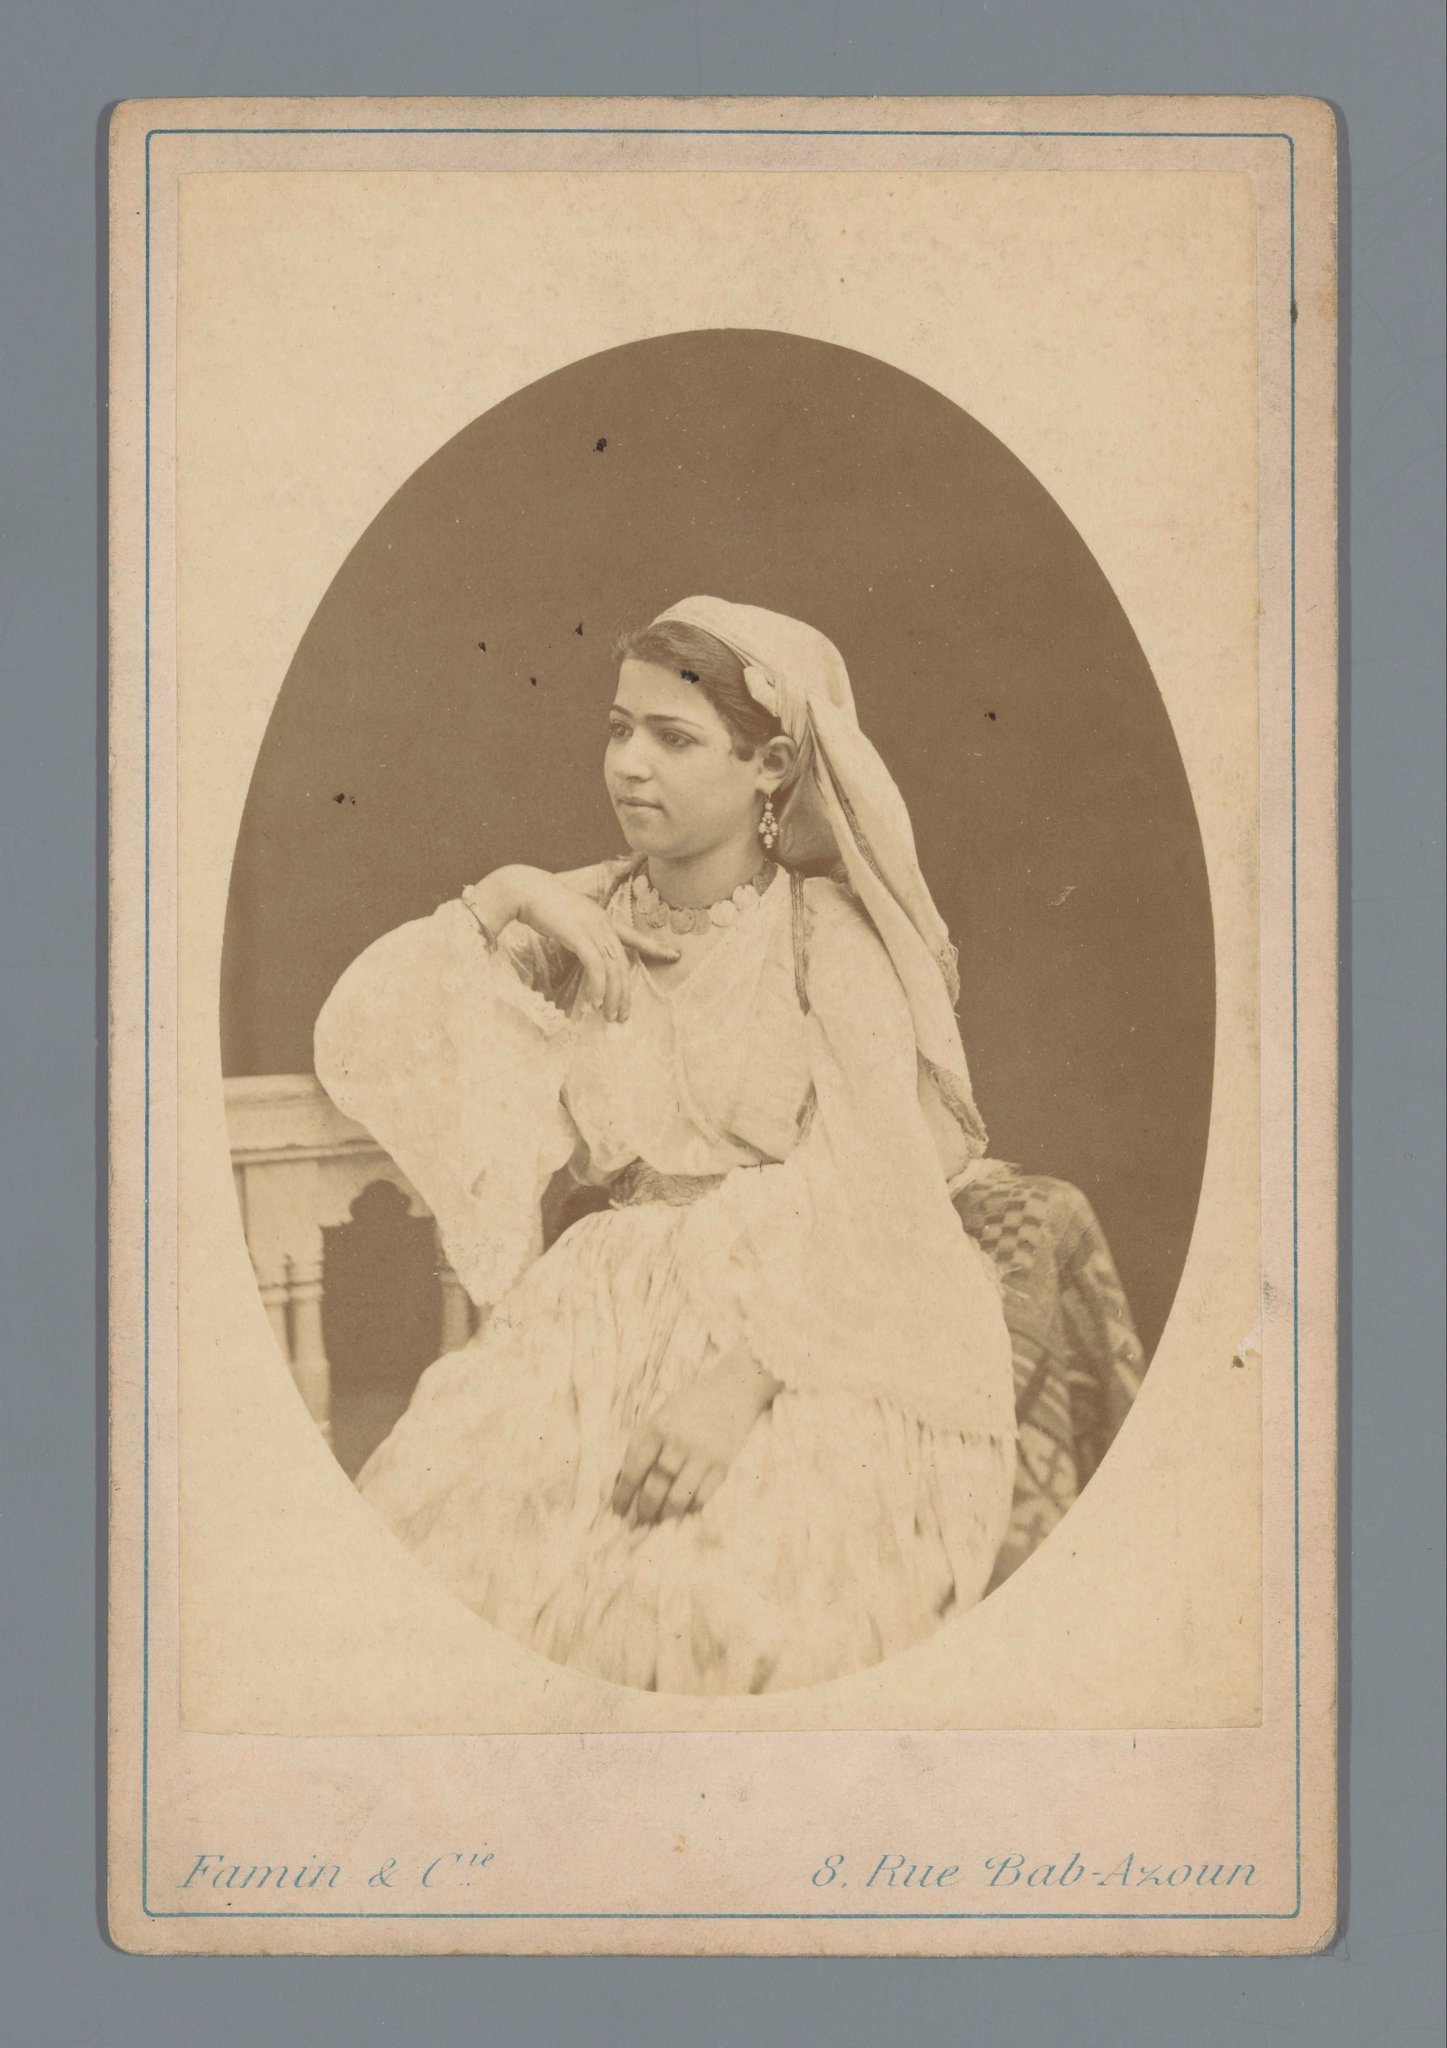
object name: cabinet photograph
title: Jonge Moorse vrouw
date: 1863-1889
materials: cardboard, photographic support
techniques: albumen print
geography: algeria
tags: clothes, costume, anonymous historical person portrayed - bb - woman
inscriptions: inscription: ‘8, Rue Bab-Azoun’, inscription: ‘Alger/ 8, Rue Bab-Azoun, 8’, inscription: ‘Jeune Mauresque’